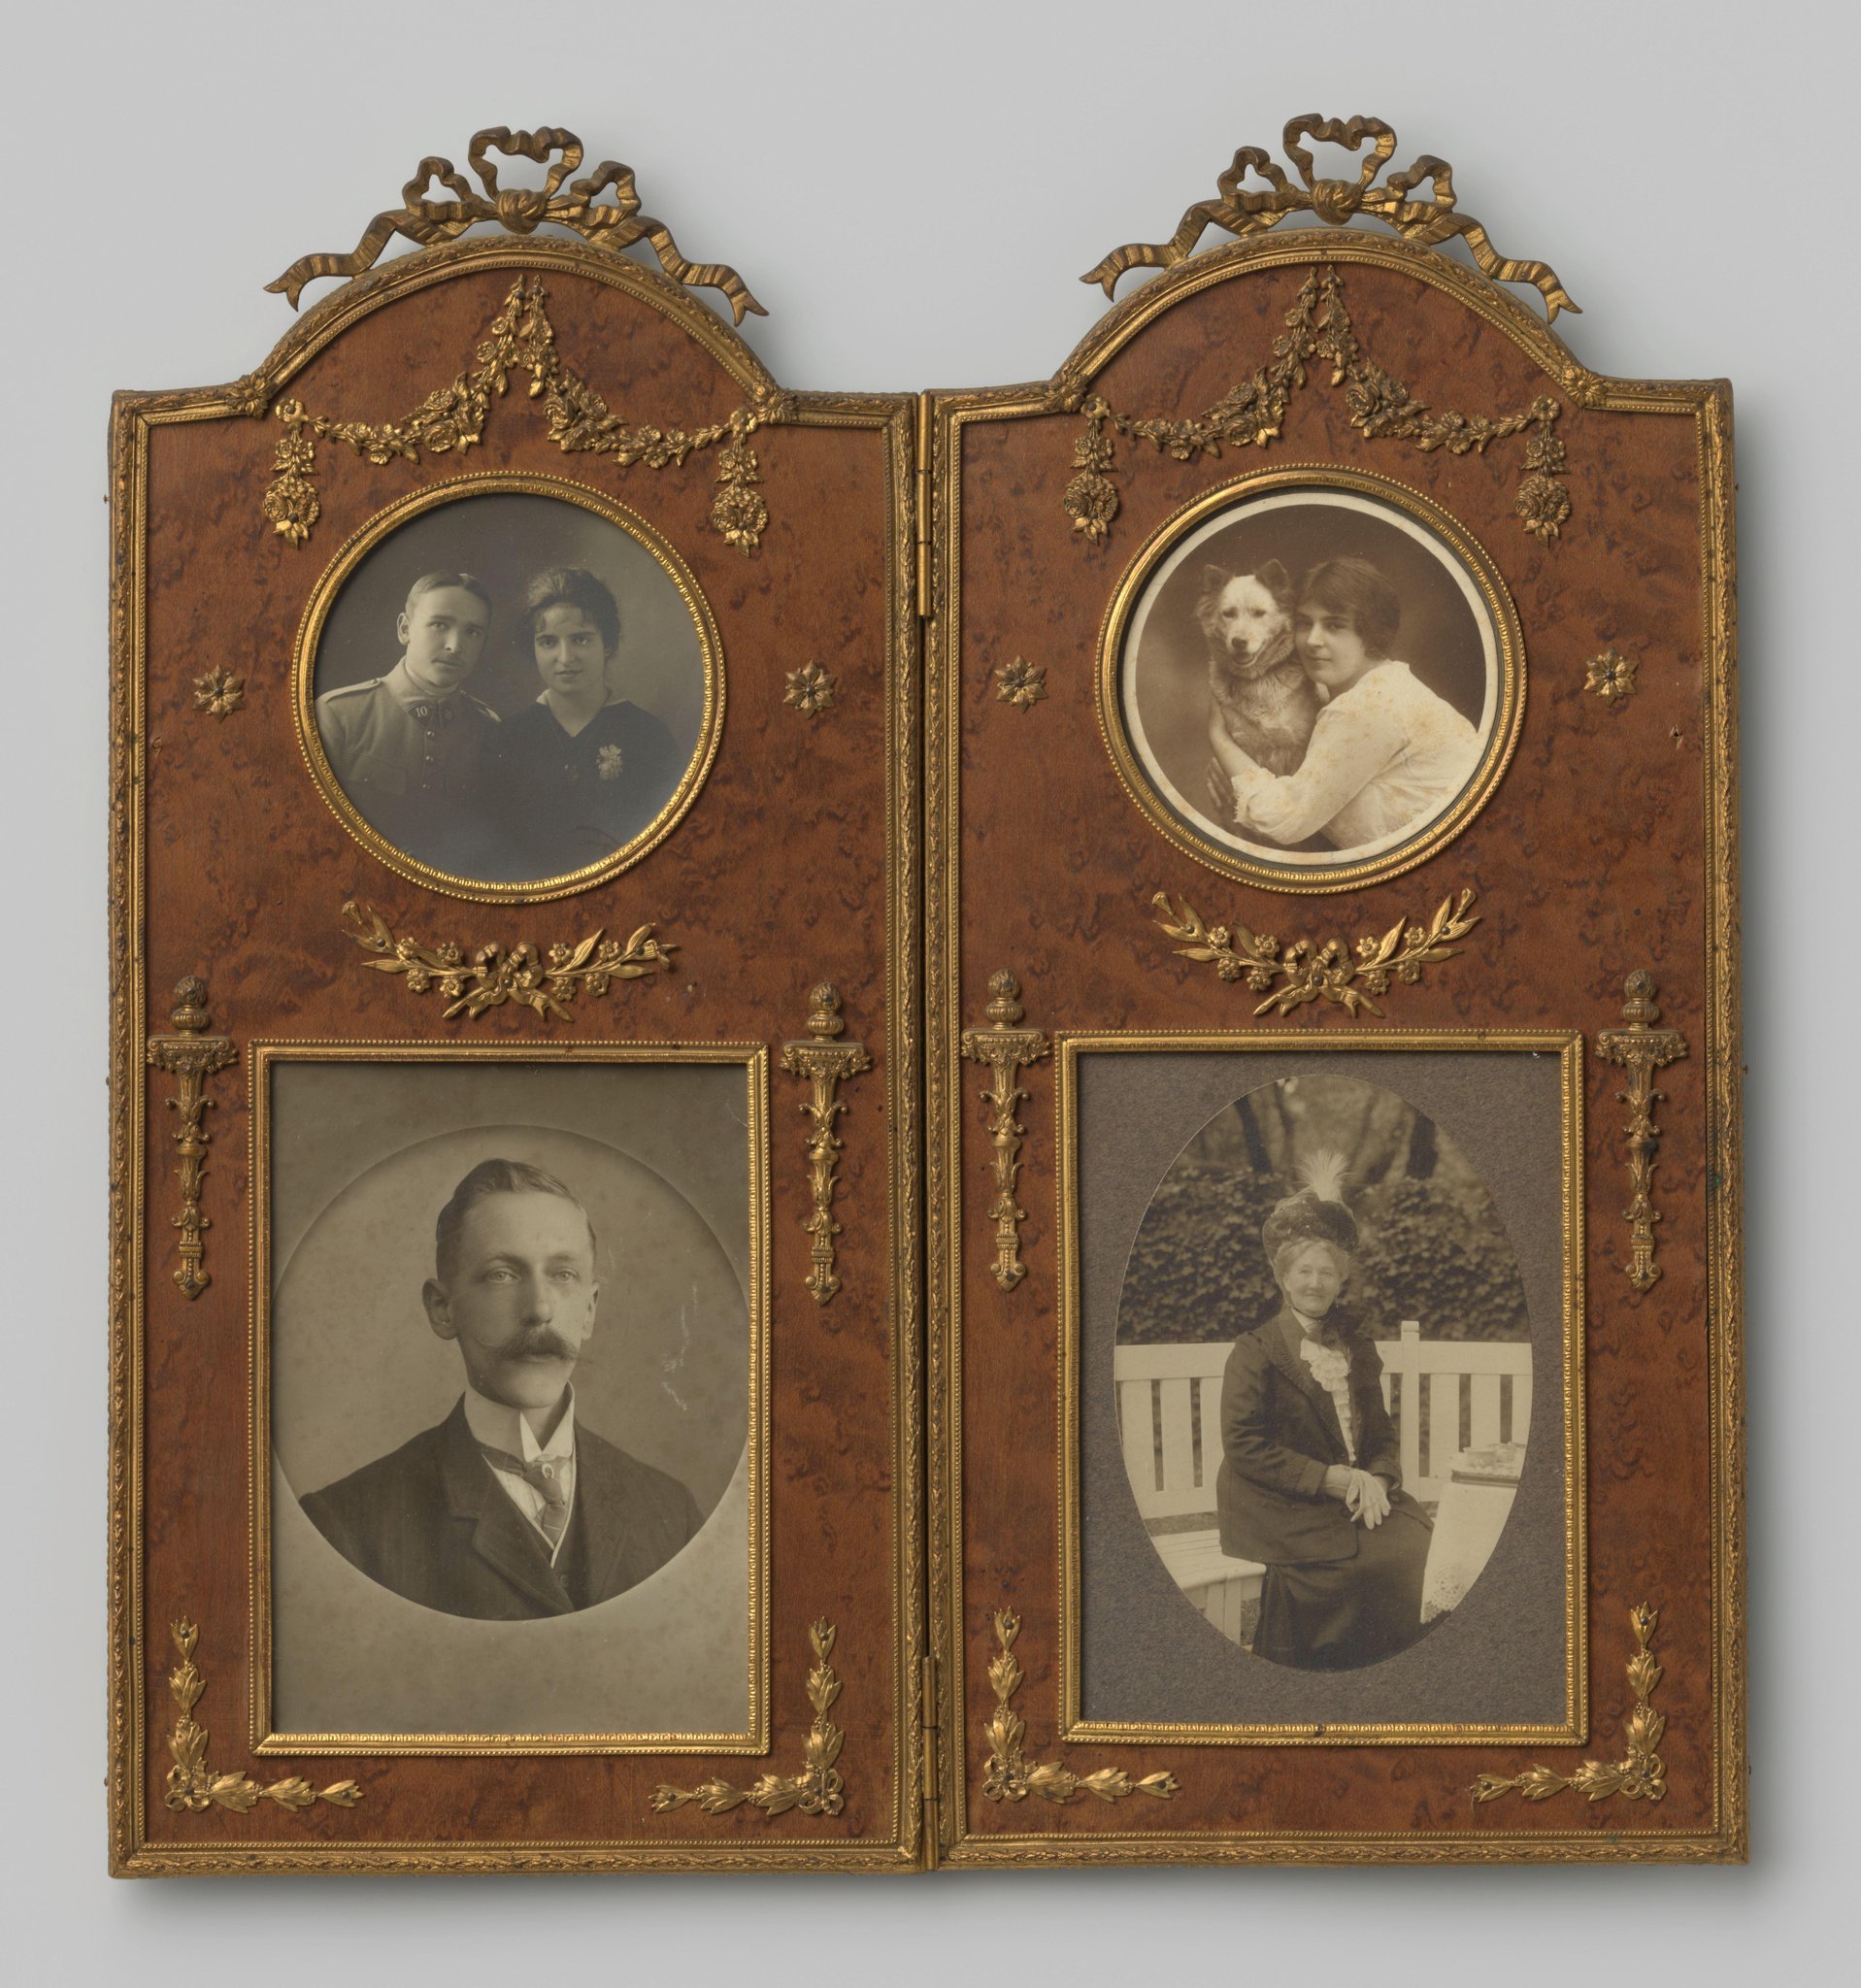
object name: frame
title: Vier portretten van een onbekende man en vrouw, een onbekende vrouw met hond, een onbekende man met snor en een onbekende vrouw in tuin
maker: Anonymous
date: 1880-1900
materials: paper, cardboard, glass, metal, wood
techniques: gelatin silver print, gilding, veneer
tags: adult woman, adult man, anonymous historical person portrayed, couple of lovers, dog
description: Dubbelklapbare lijst met vier portretten van vijf onbekende personen.